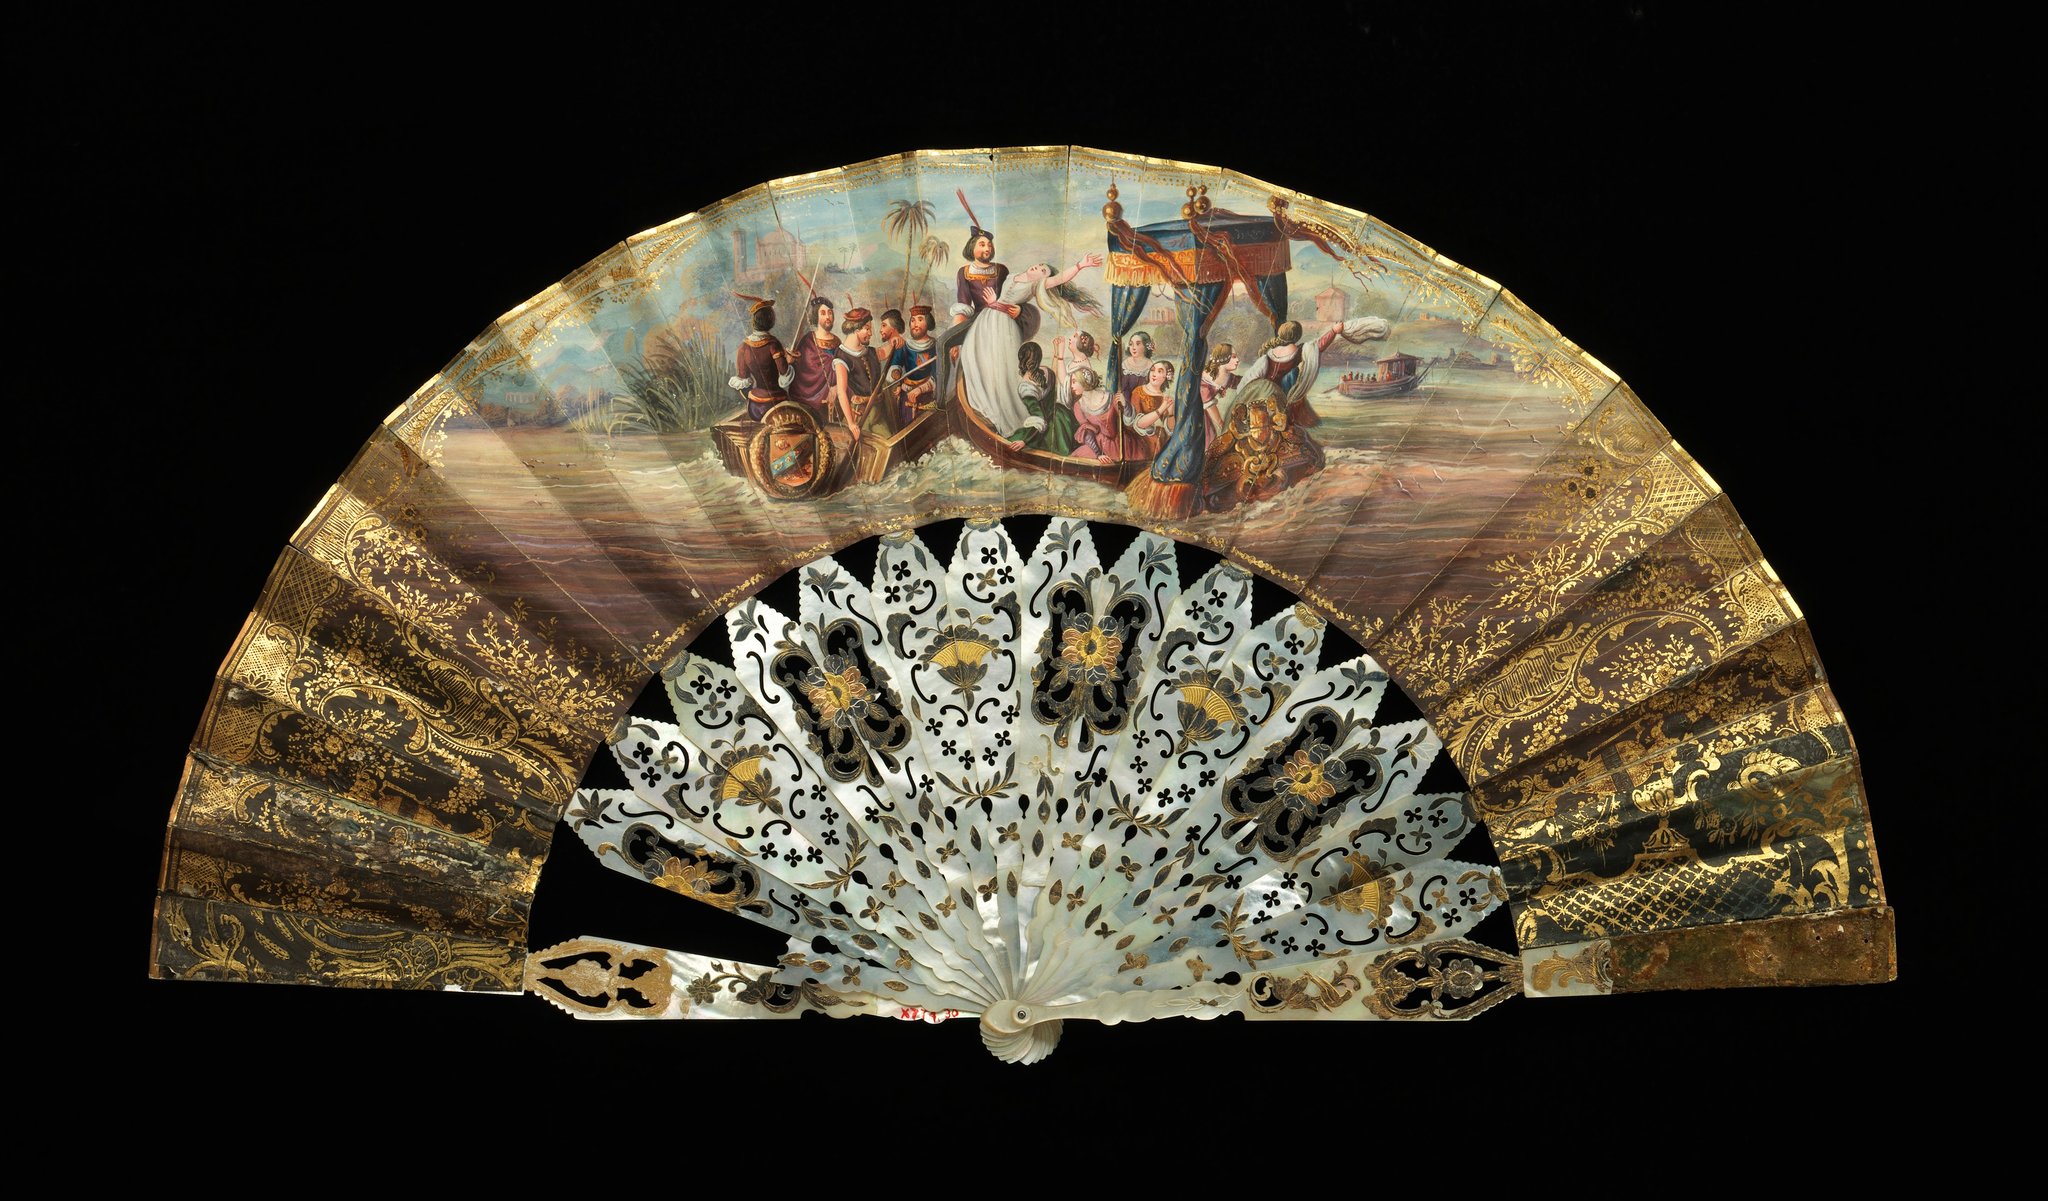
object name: fan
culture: french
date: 1840-1870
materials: gouache, metal, mother of pearl, paper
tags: men,women,boats